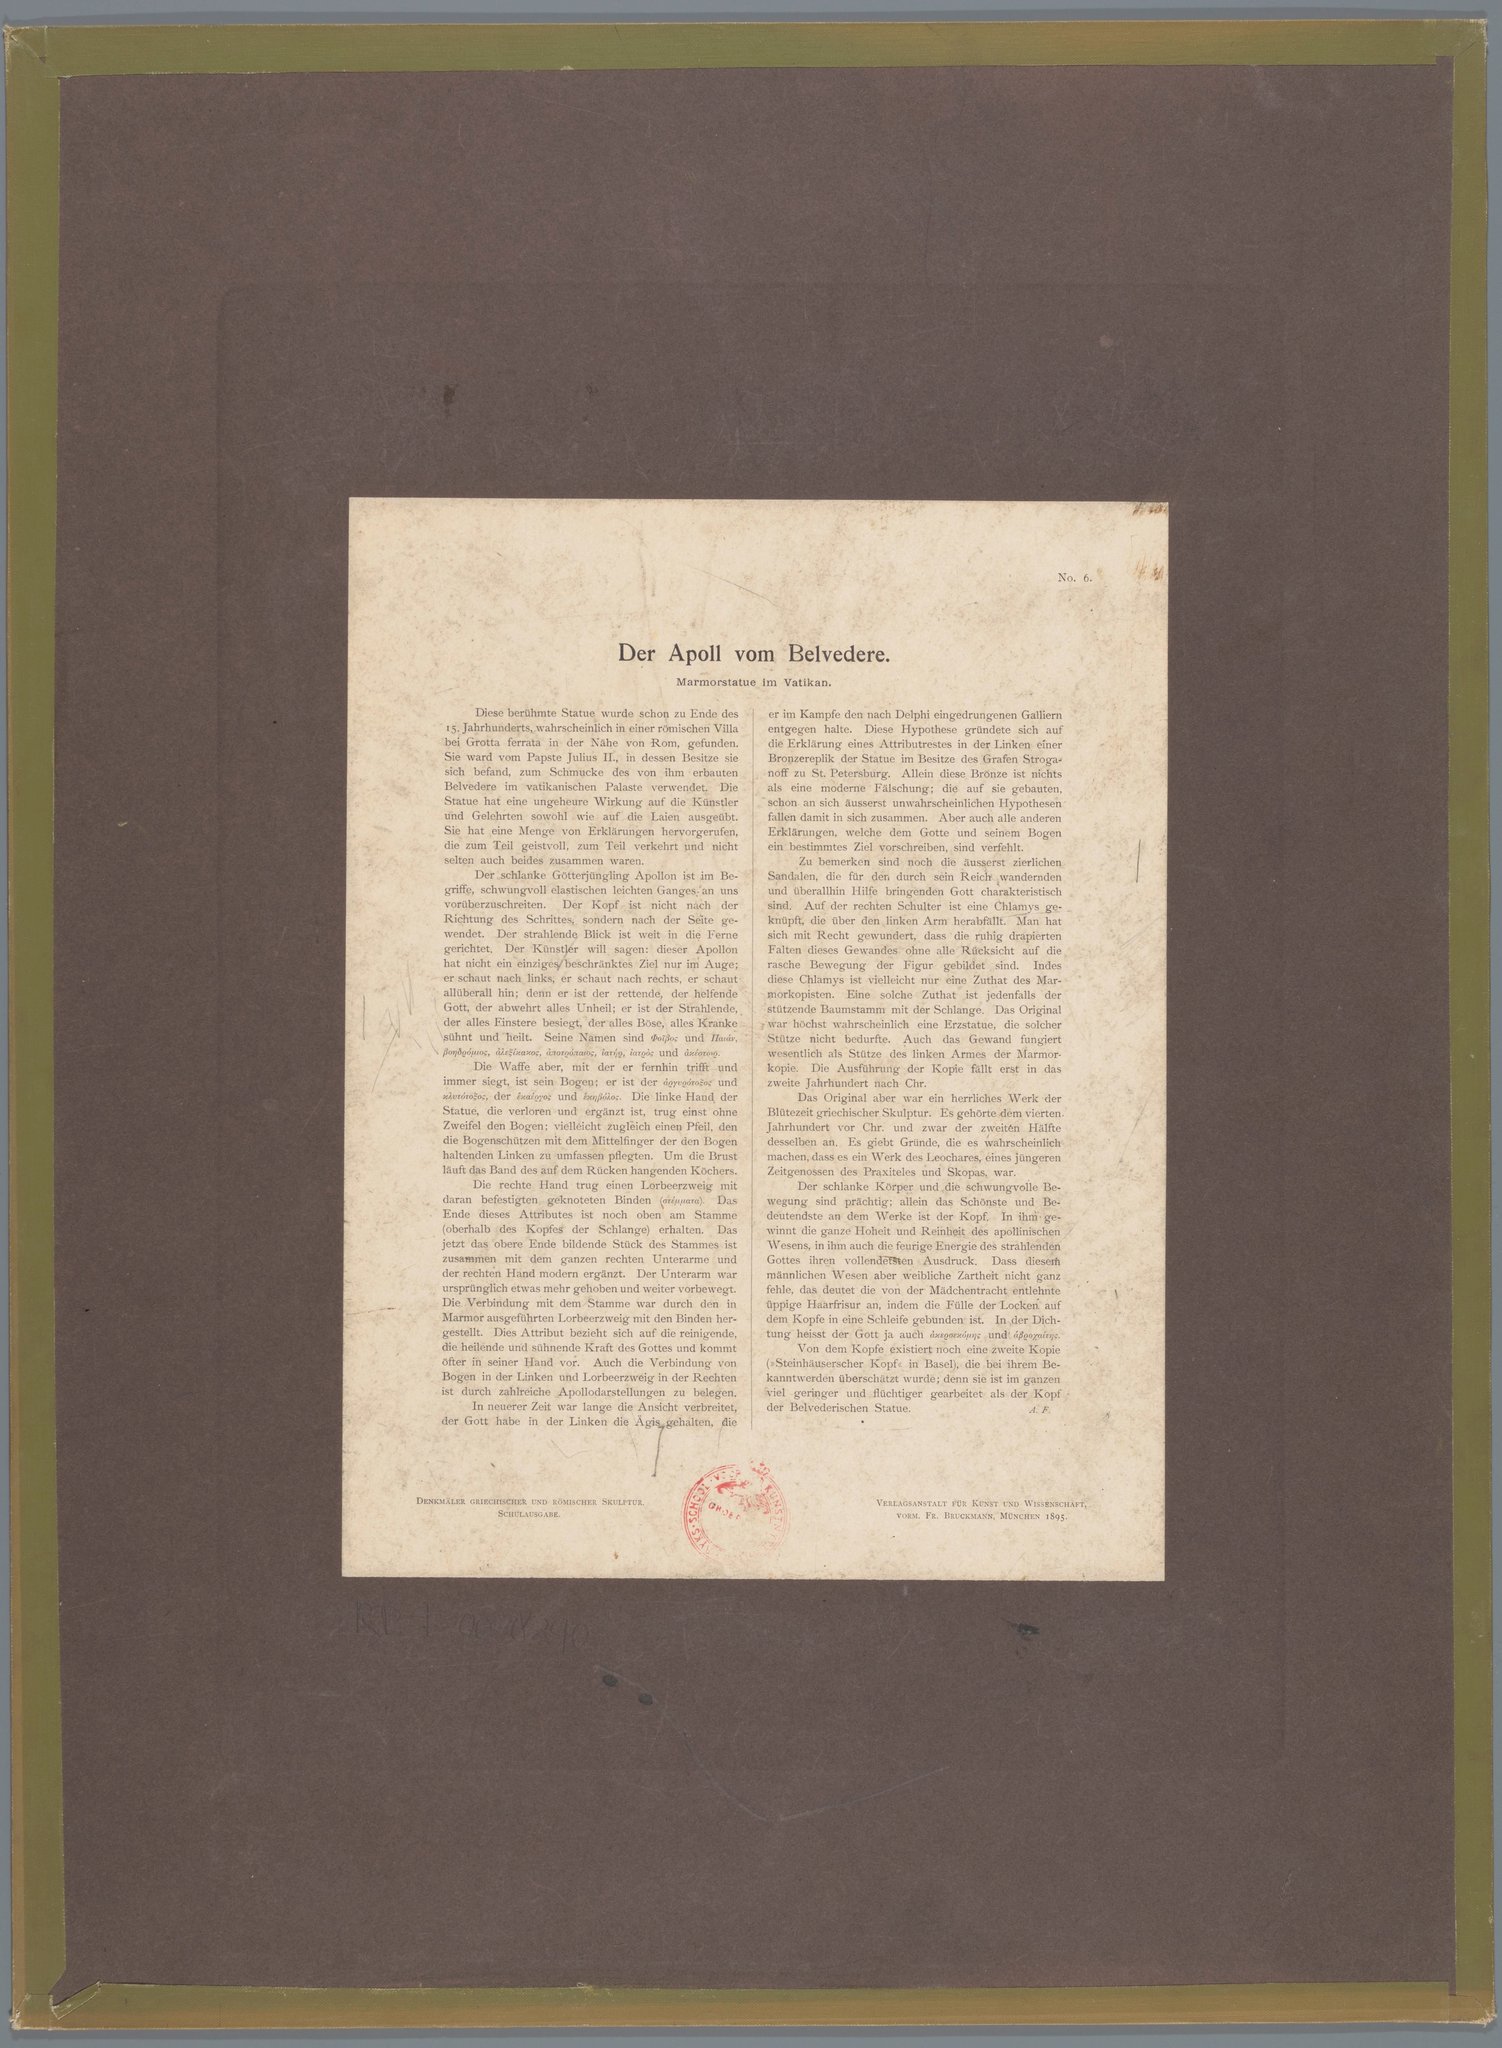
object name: photograph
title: Apollo van Belvedère in de Vaticaanse Musea te Vaticaanstad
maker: Anonymous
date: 1895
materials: cardboard, paper, ink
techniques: photograph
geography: munich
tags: (story of) apollo (phoebus), sculpture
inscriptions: number: ‘No. 6.’, collector's mark: Lugt 3937, inscription: